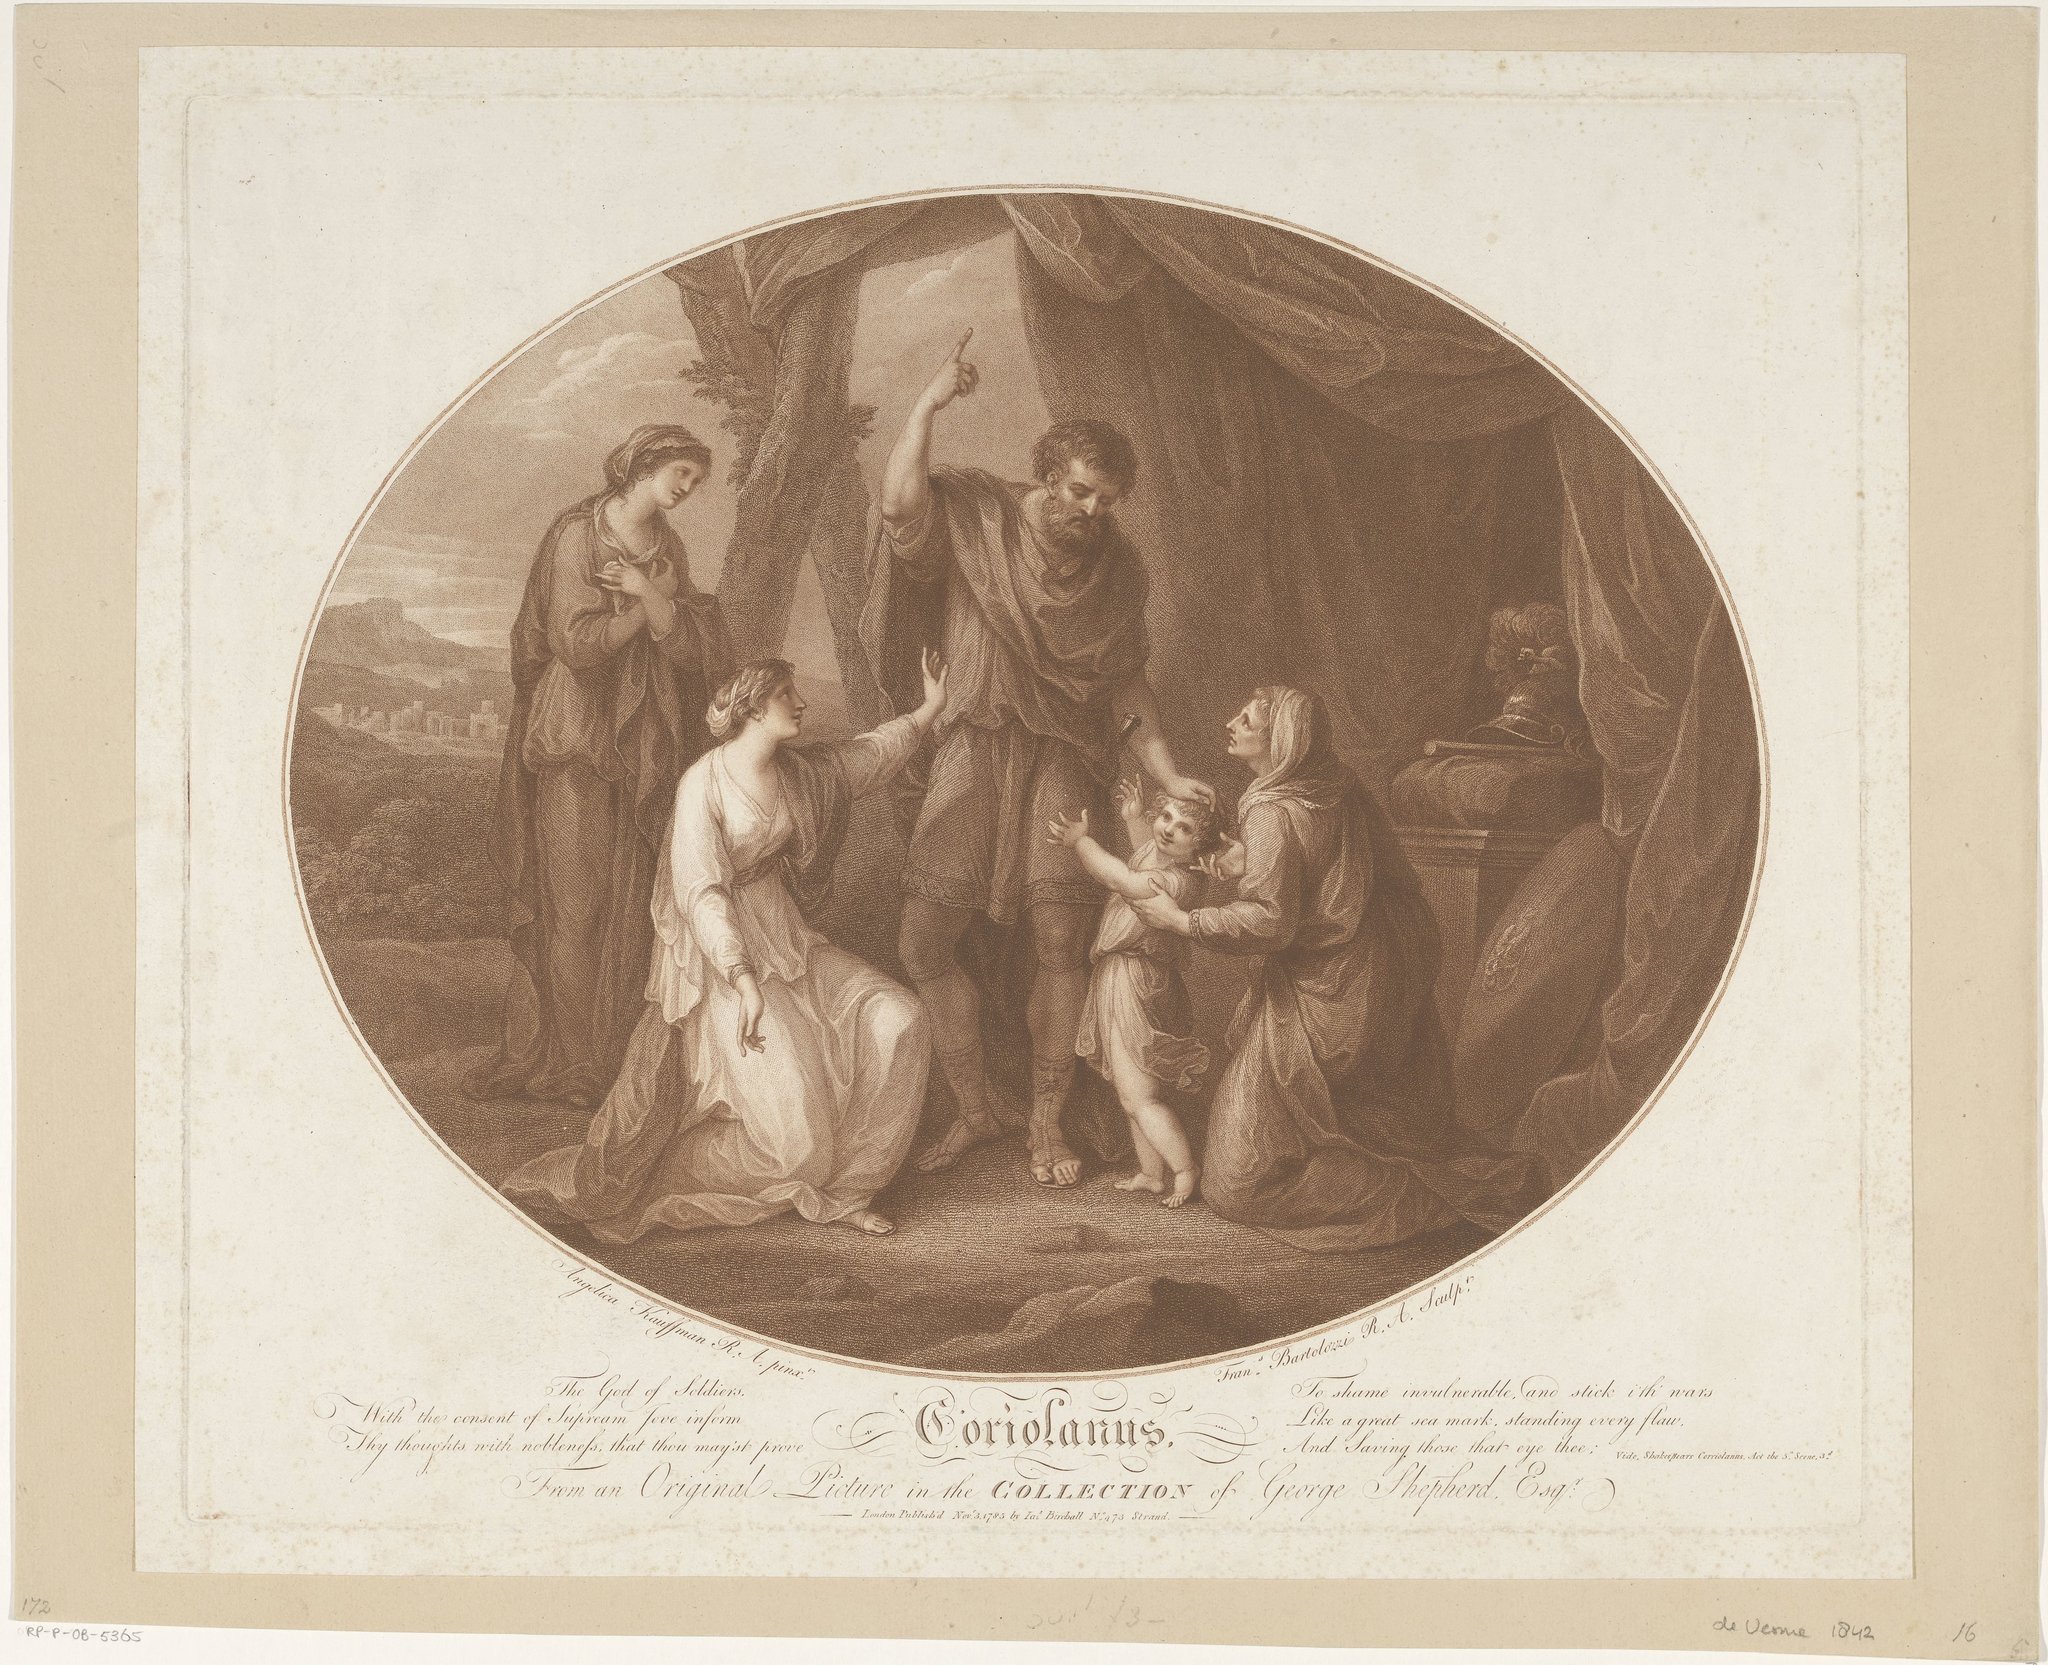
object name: print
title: Coriolanus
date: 1785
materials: paper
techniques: etching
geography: london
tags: (story of) coriolanus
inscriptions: collector's mark: Lugt 2165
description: Scène uit het toneelstuk Coriolanus van William Shakespeare, met de militair Gaius Marcius Coriolanus een kind en drie vrouwen. Engels vers onder de voorstelling.